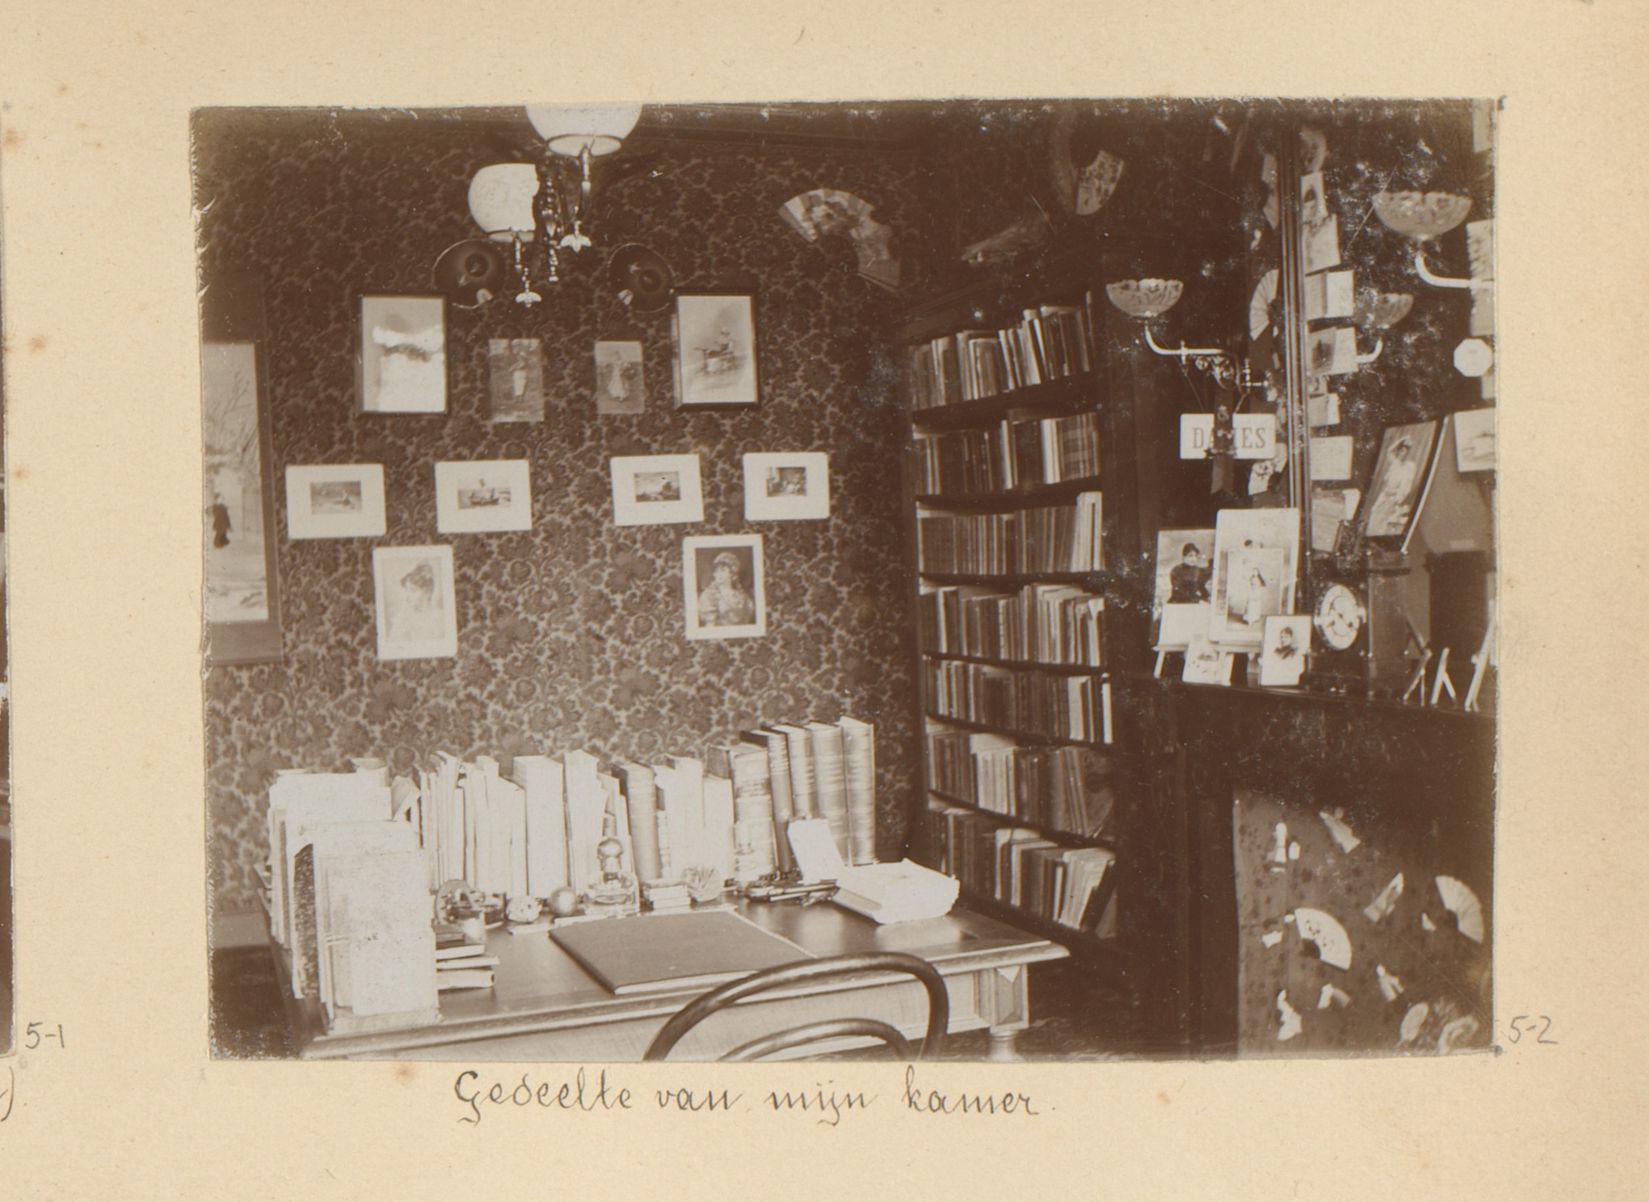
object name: album leaf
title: Gedeelte van mijn kamer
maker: hendrik herman van den berg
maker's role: amateurfotograaf, jurist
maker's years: 1875-1944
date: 1890-1894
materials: paper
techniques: collodion silver print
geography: amsterdam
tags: bookshelves, writing accessories, interior ~ representation of a building, amsterdam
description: Foto 2 op albumblad 5 uit album "Amsterdam 1890-1894".